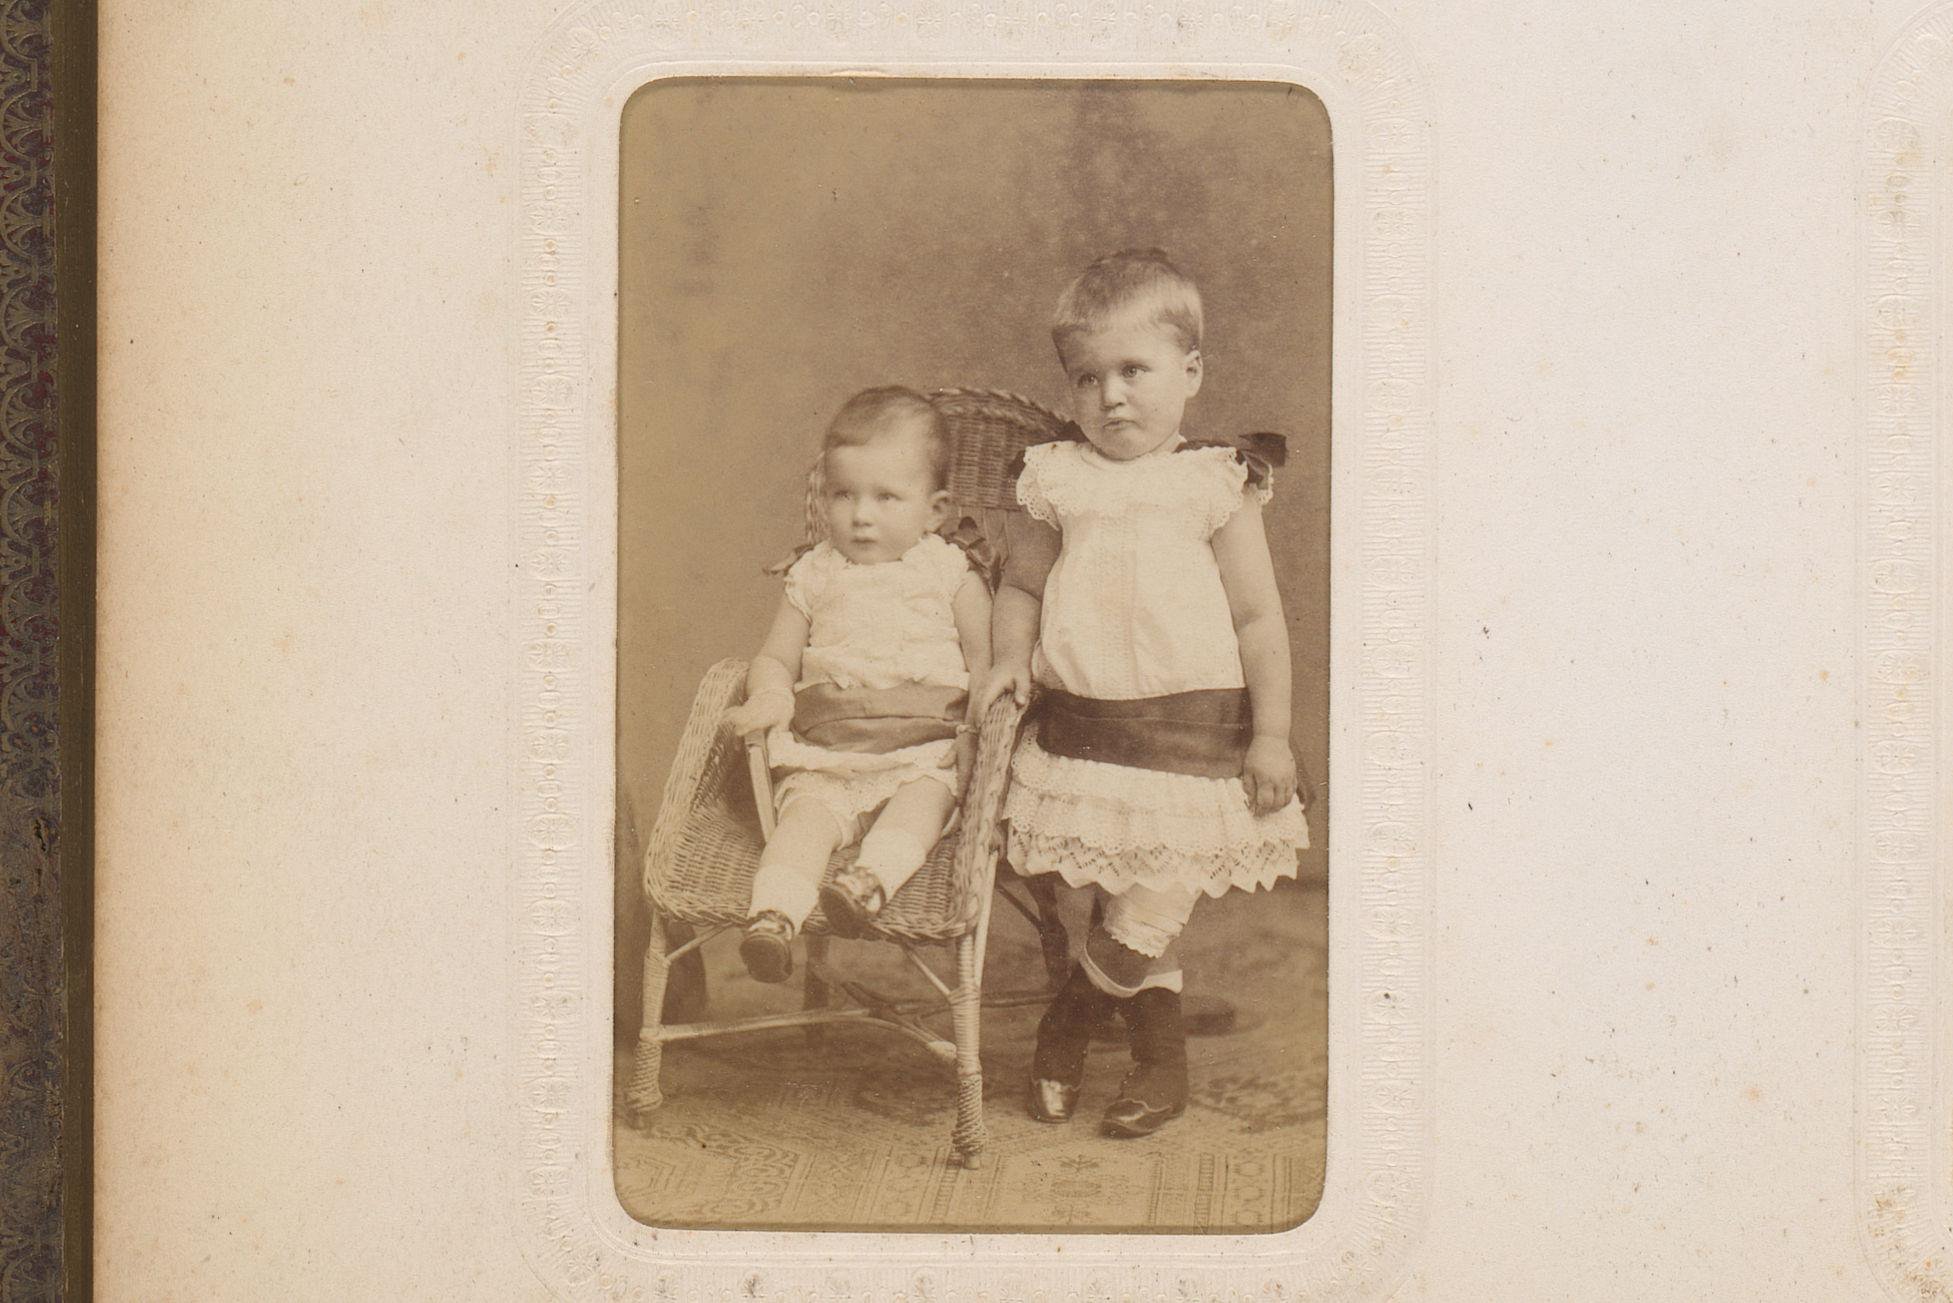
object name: album leaf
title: Portret van een zittend meisje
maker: Anonymous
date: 1880-1900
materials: cardboard, celluloid, photographic support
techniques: albumen print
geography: netherlands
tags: sitting figure - aa - female human figure, historical persons - bb - woman, toddler (female)